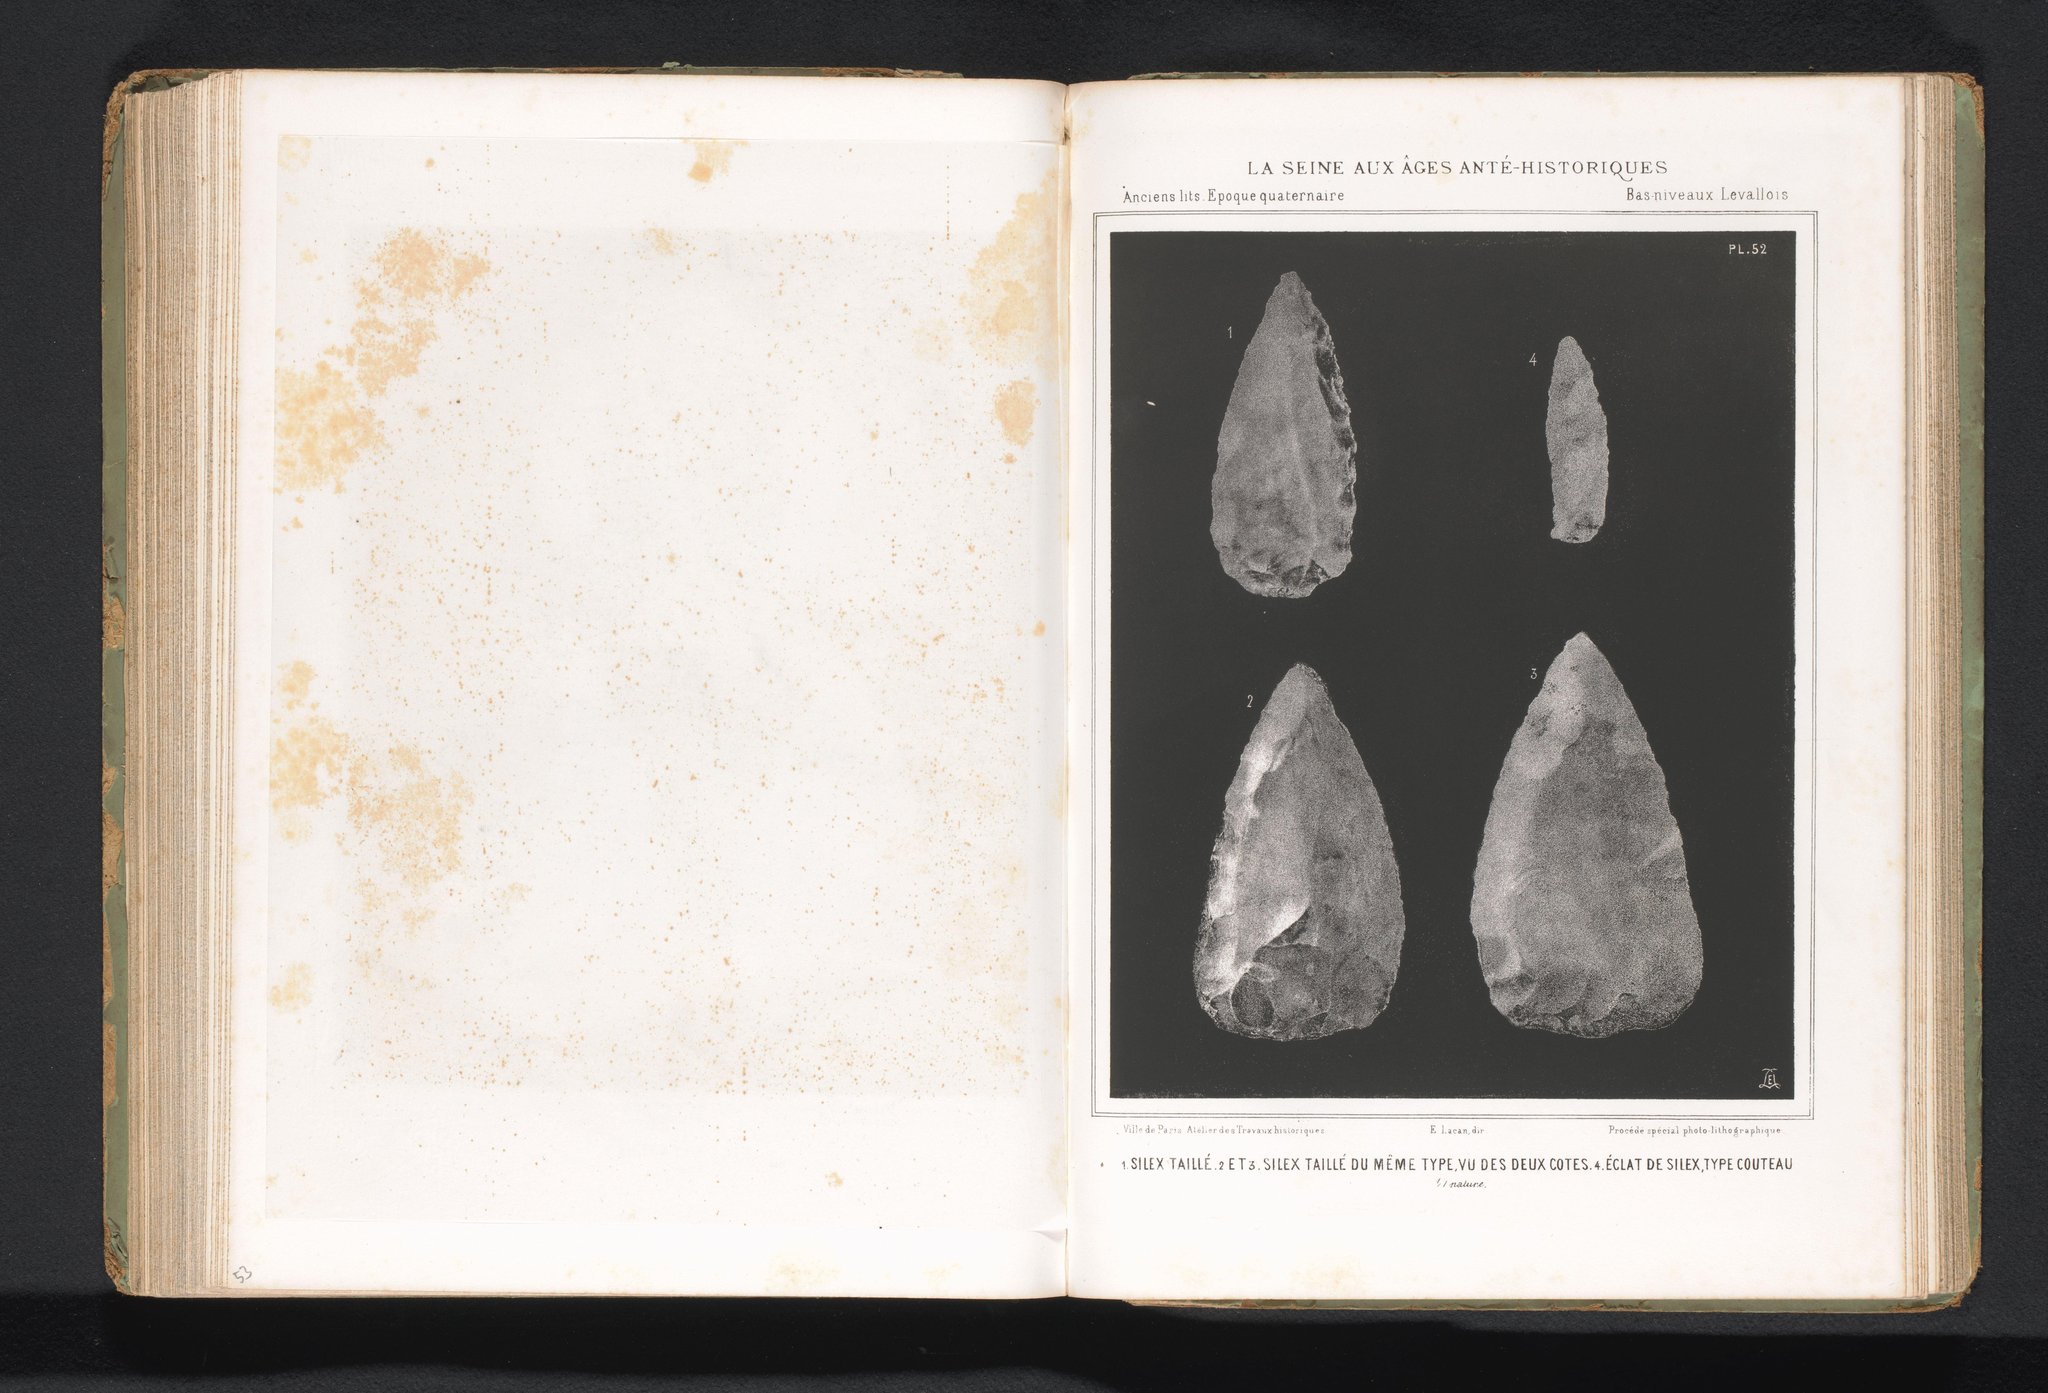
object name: page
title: Instrumenten van vuursteen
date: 1864-1869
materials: paper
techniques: photolithography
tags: tools, aids, implements ~ crafts and industries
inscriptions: inscription: ‘Procédé spécial photo-lithographique’, inscription: ‘PL. 52’, inscription: ‘1. SILEX TAILLÉ. 2. et 3. SILEX TAILLÉ DU MÊME TYPE, VU DES DEUX COTES. 4. ÉCLAT DE SILEX, TYPE COUTEAU’, inscription: ‘1/1 nature’, monogram: ‘EL’